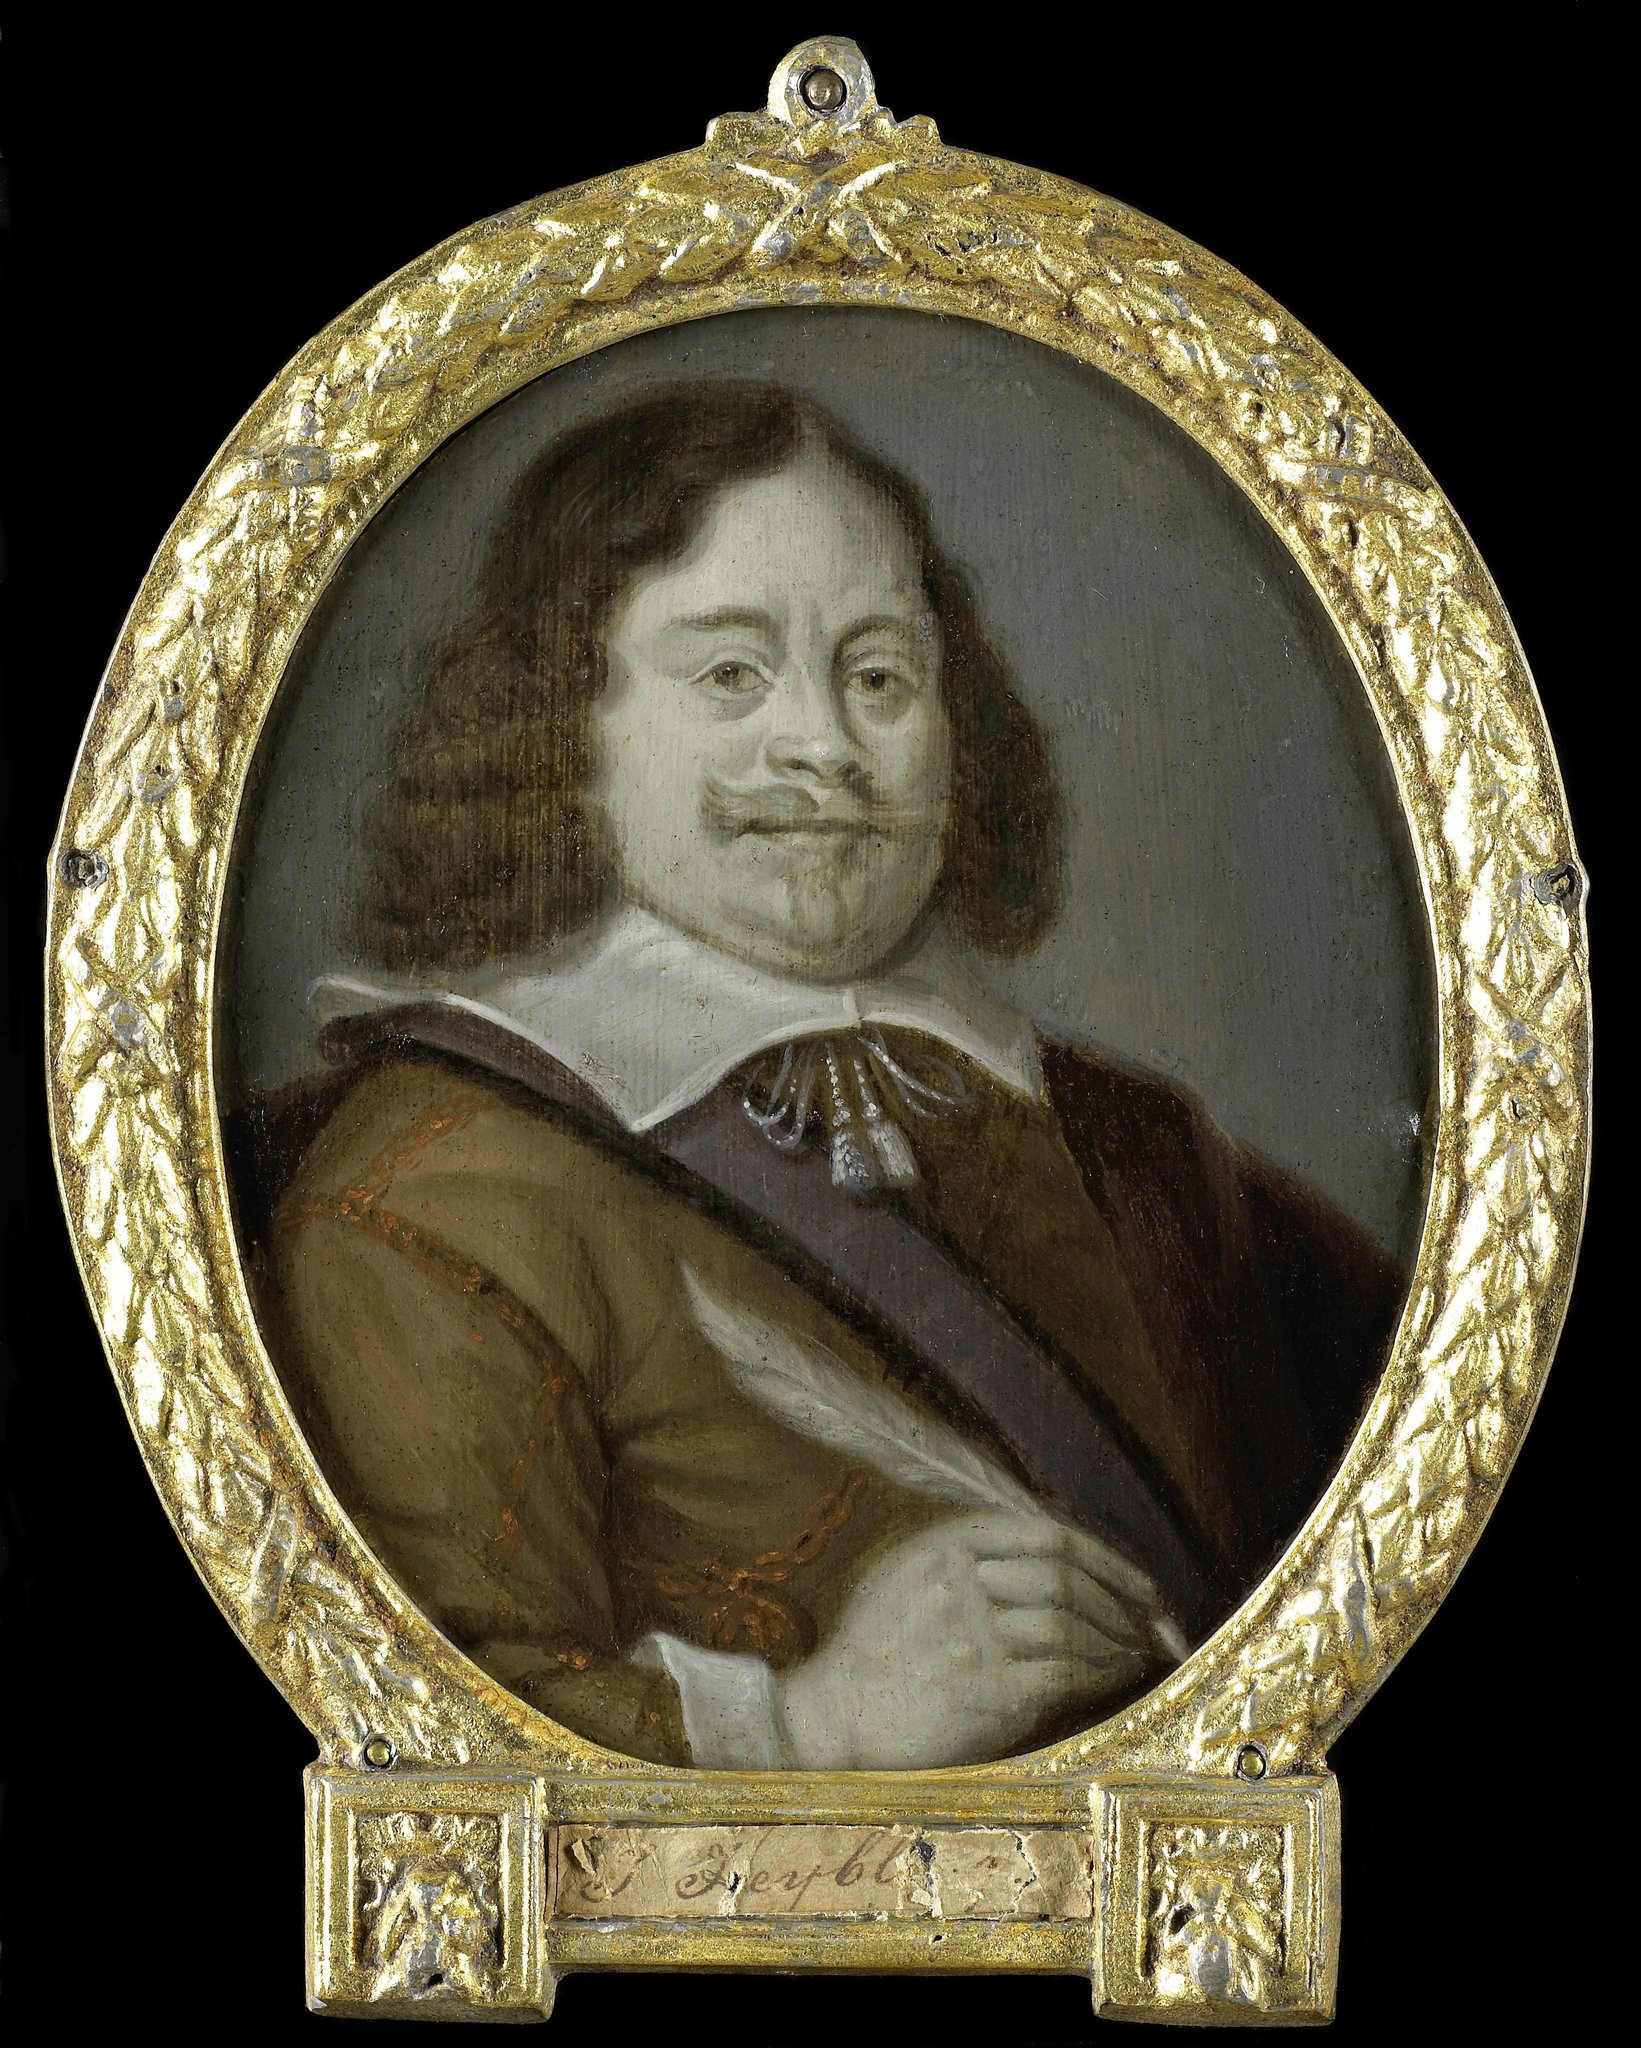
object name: painting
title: Portrait of Joannes Cools (born 1611), Jurist, Historian and Latin Poet in Hoorn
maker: arnoud van halen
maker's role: draughtsman, painter, print maker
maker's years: 1673-1732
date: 1700-1732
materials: oil, metal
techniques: grisaille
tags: hoorn (north holland), enkhuizen, johannes cools, portrait of a writer, writer, poet, author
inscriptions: inscription: ‘Joh. Cools R.Z. Hr. van Tetterode. Circa 1615’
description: Portret van Joannes Cools (geb 1611). Rechtsgeleerde, geschiedschrijver en Latijns dichter te Hoorn. Buste in ovaal, naar rechts, pen in de rechterhand. Onderdeel van een verzameling portretten van Nederlandse dichters.